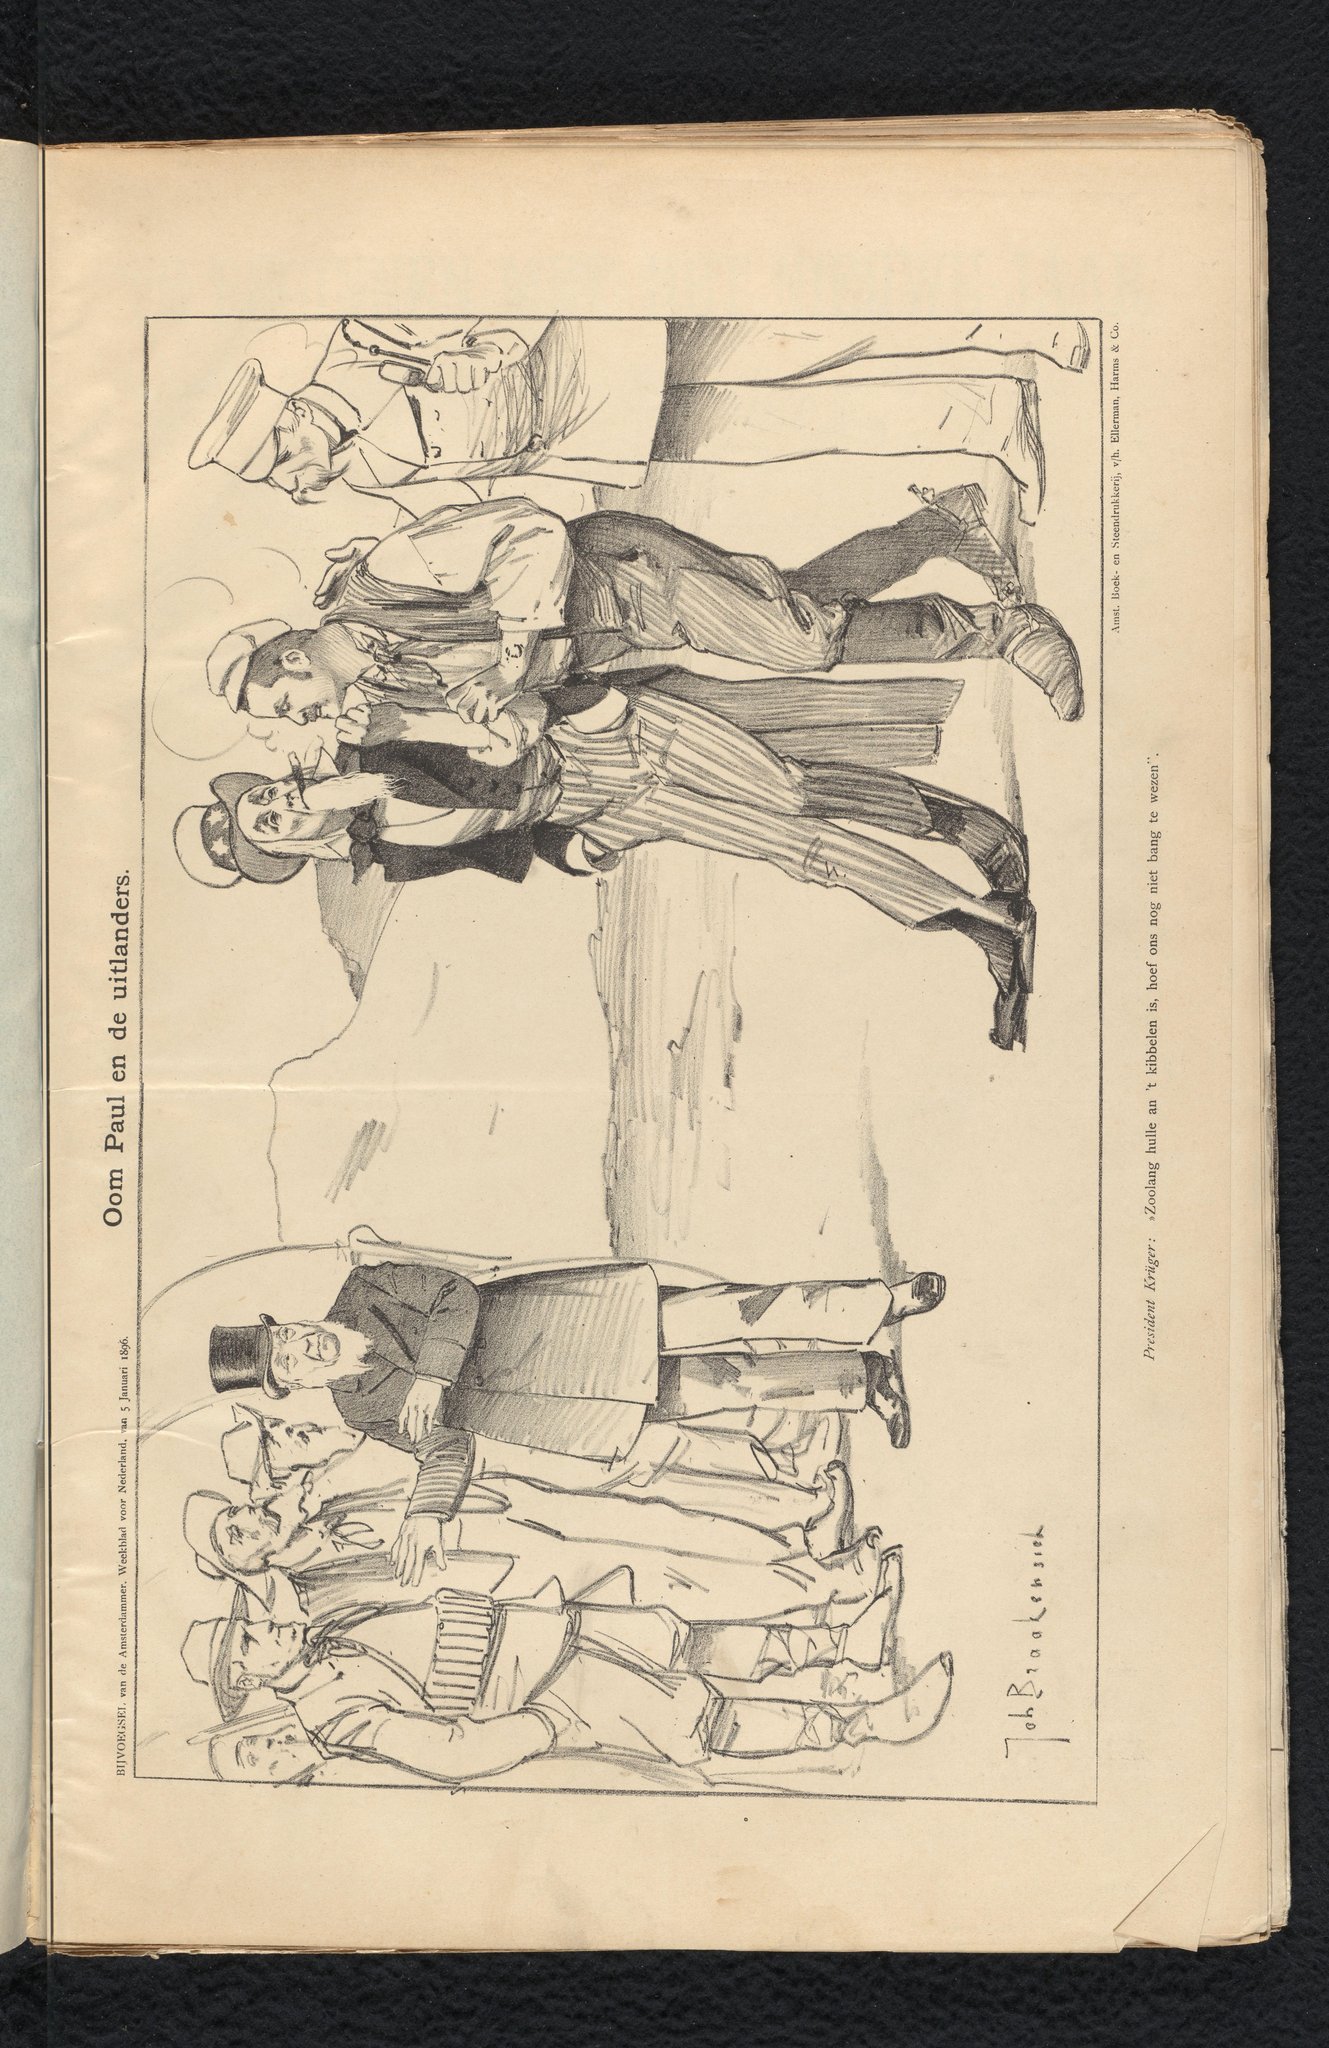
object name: cartoon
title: Oom Paul en de uitlanders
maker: johan braakensiek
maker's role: draughtsman, print maker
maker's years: 1858-1940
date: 1896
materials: paper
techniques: lithograph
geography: netherlands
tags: personifications of countries, nations, states, districts, etc., united kingdom, united states of america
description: Paul Kruger met een groep Boeren tegenover enkele 'uitlanders': Uncle Sam, een Brit en een derde persoon.